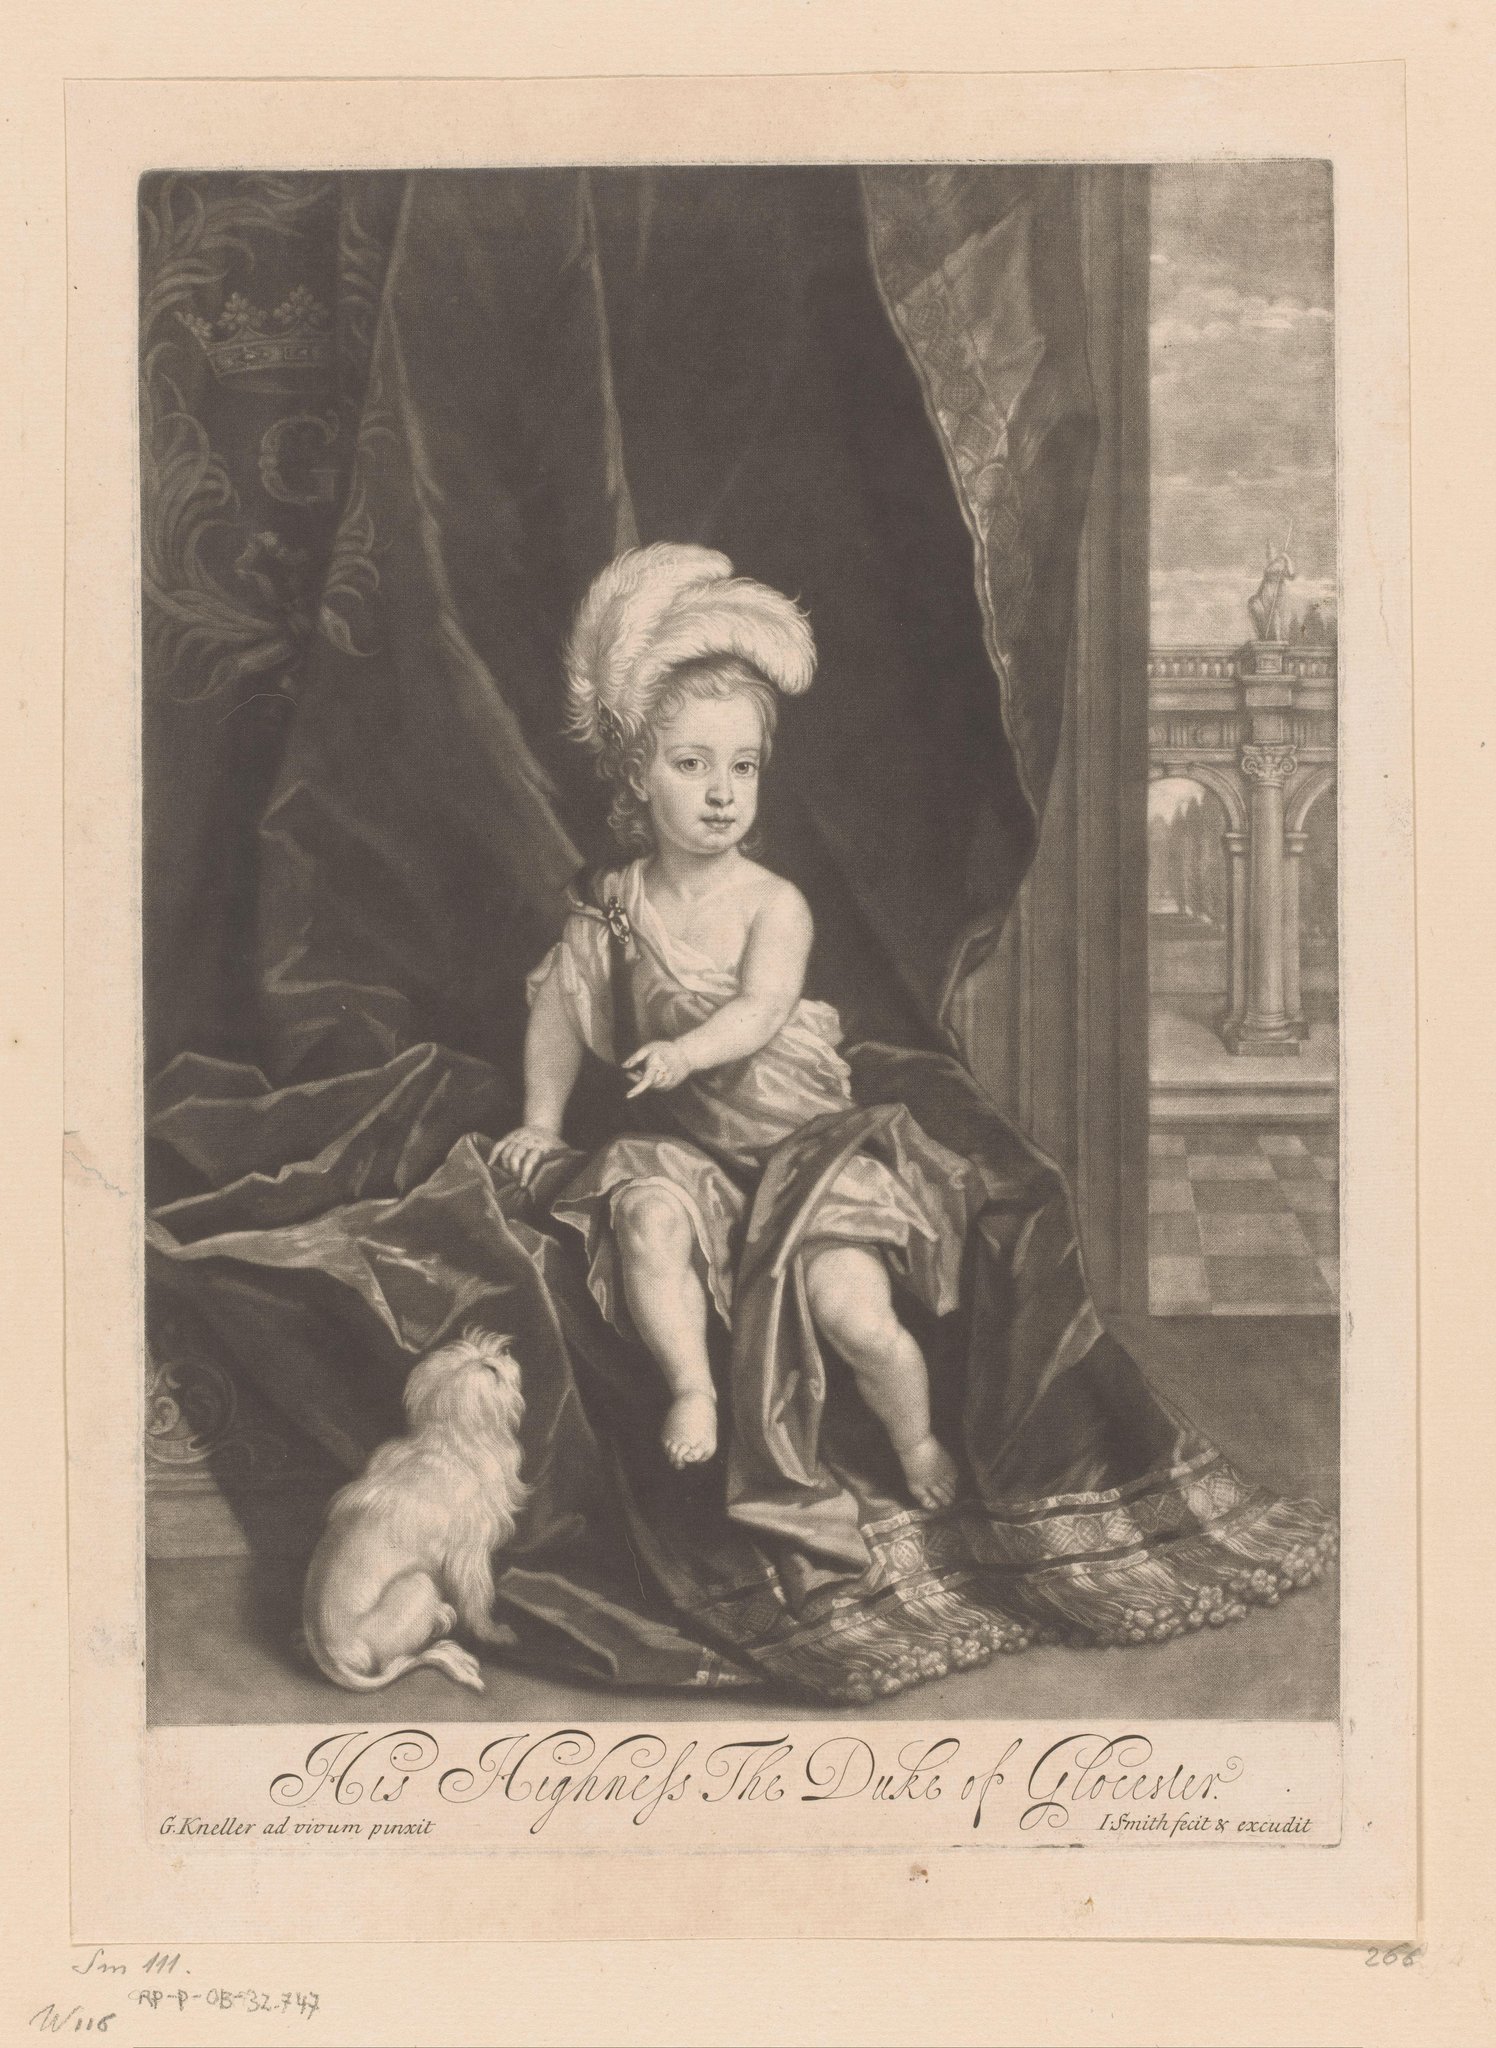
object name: print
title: Portret van William, hertog van Gloucester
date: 1695-1742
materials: paper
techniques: mezzotint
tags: historical persons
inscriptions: collector's mark: Lugt 240